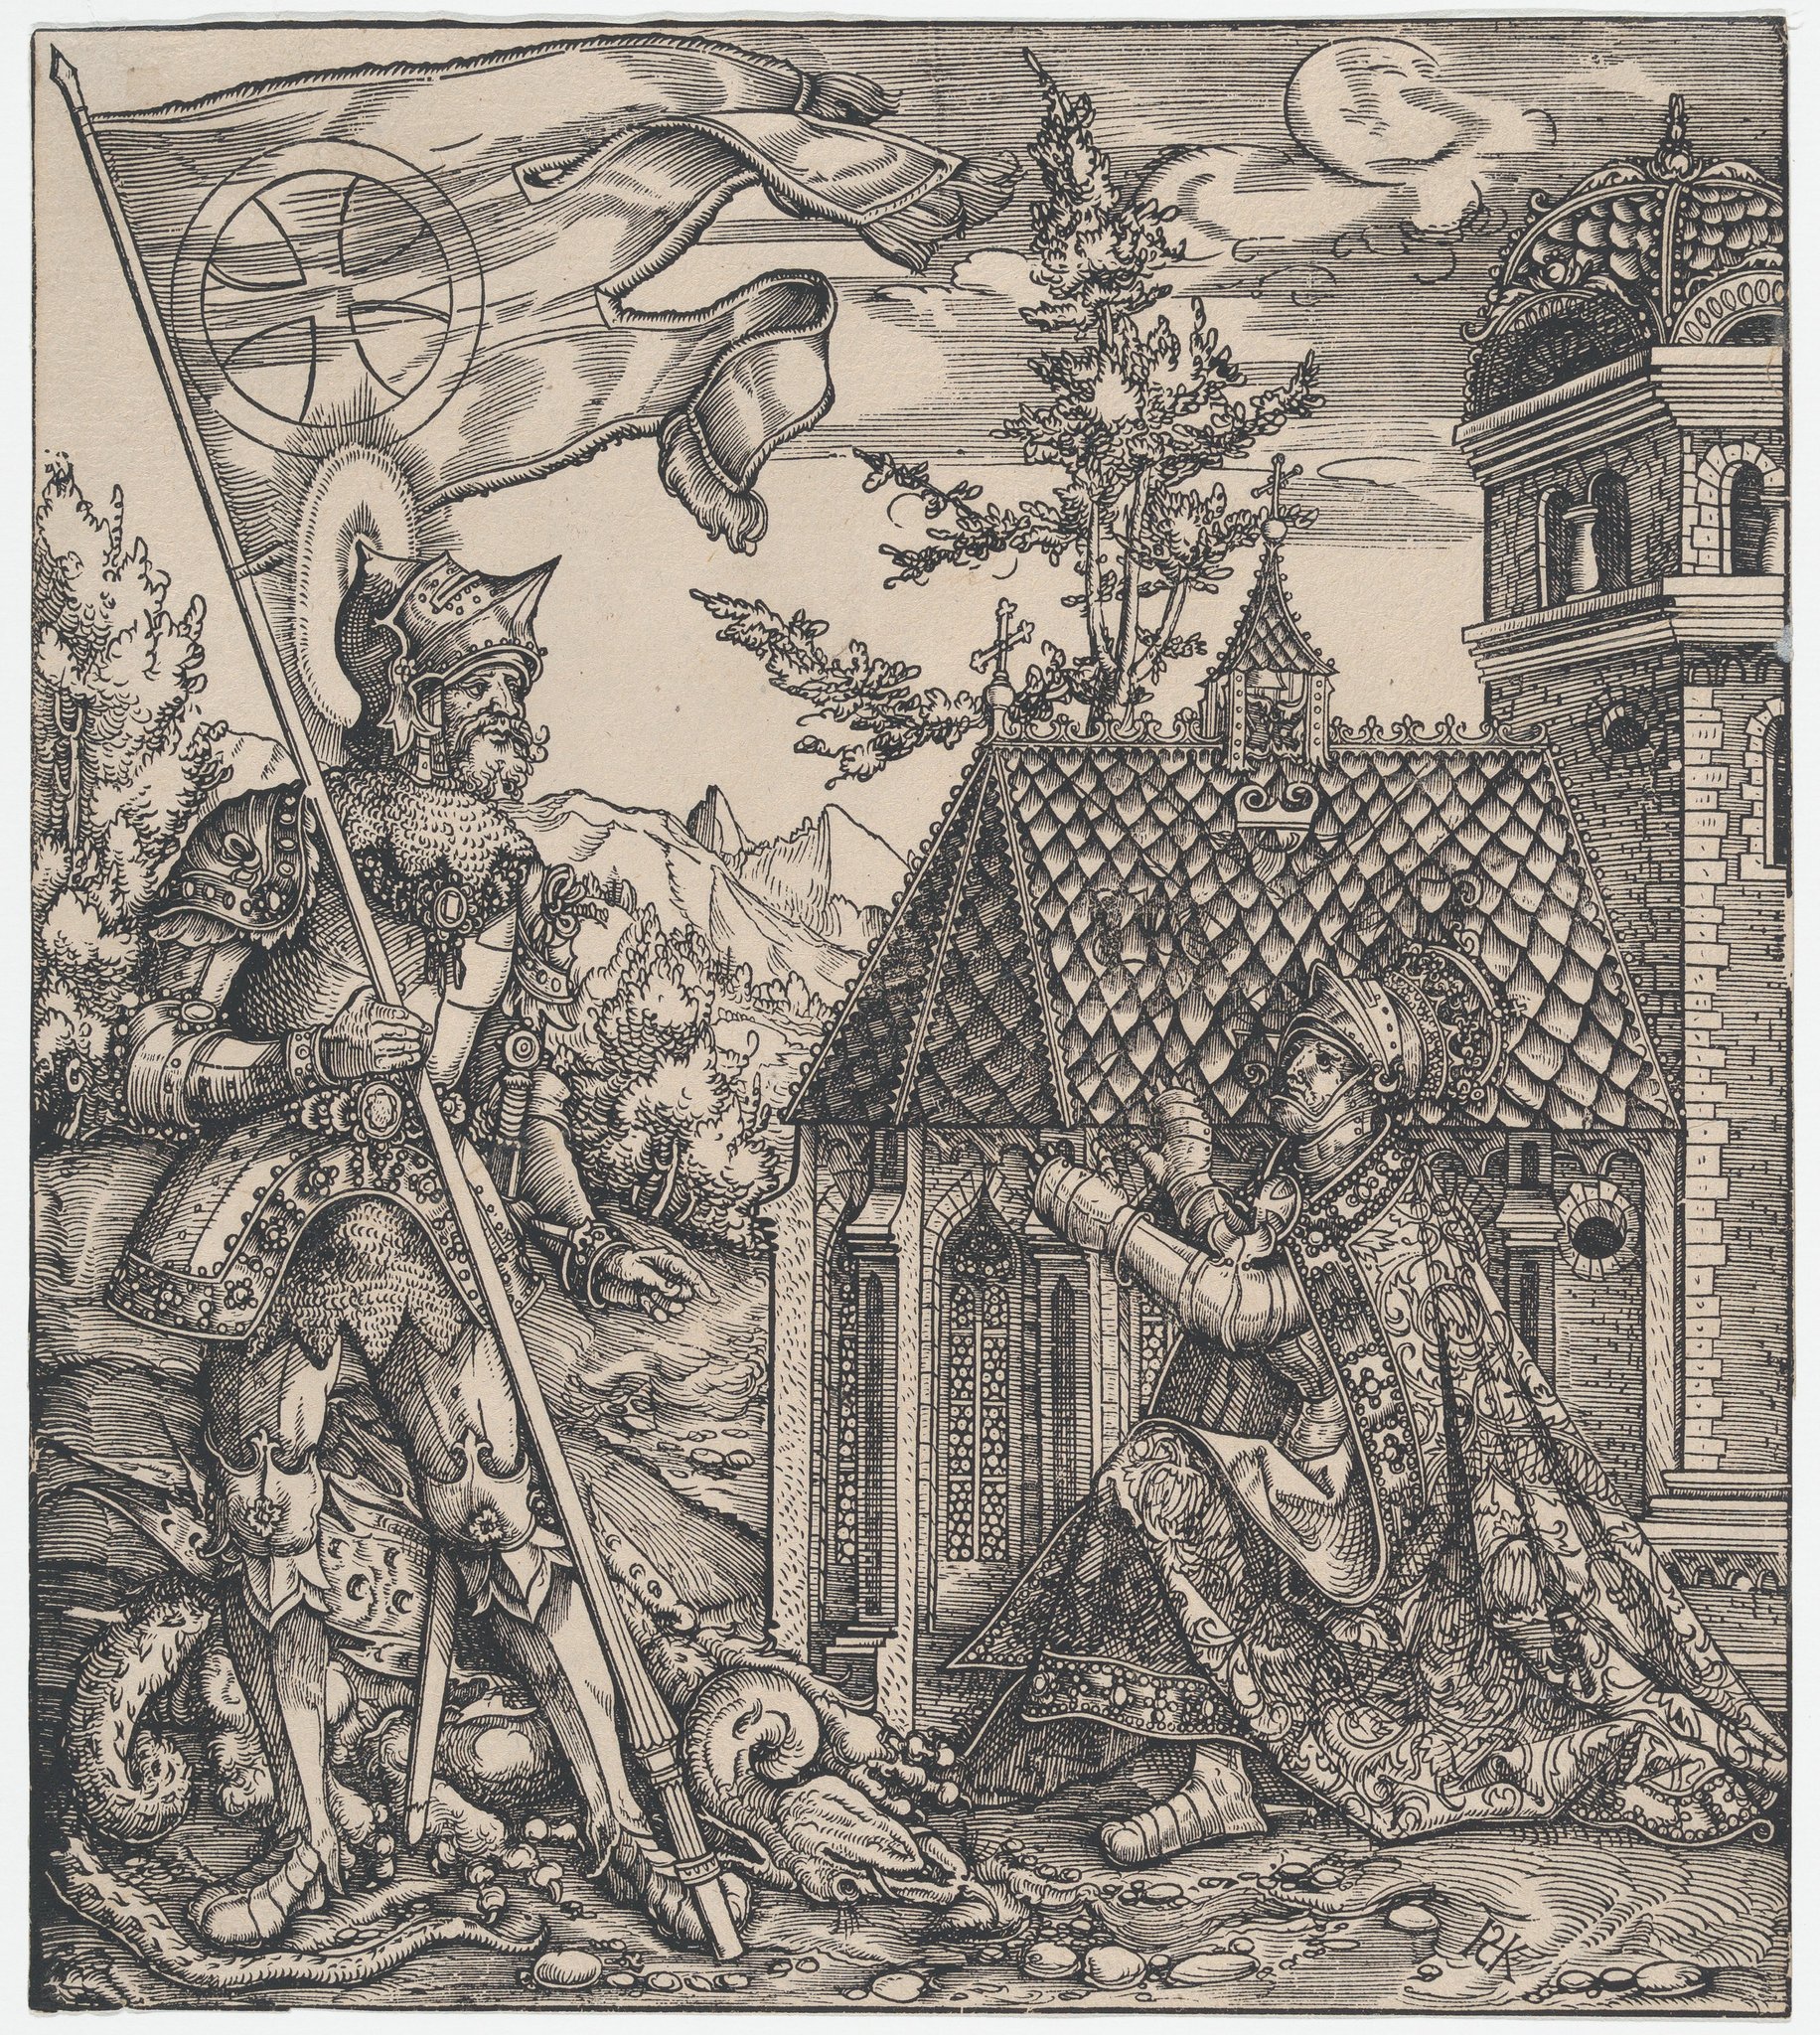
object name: print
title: St George as the Emperor's Patron Saint, from "The Habsburg Saints" (Images de Saints et de Saints Issus de la Famille de L'Emperor Maximilian I)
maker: hans springinklee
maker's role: artist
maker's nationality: german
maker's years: 1495-1530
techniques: woodcut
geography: vienna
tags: saint george,saints,flags